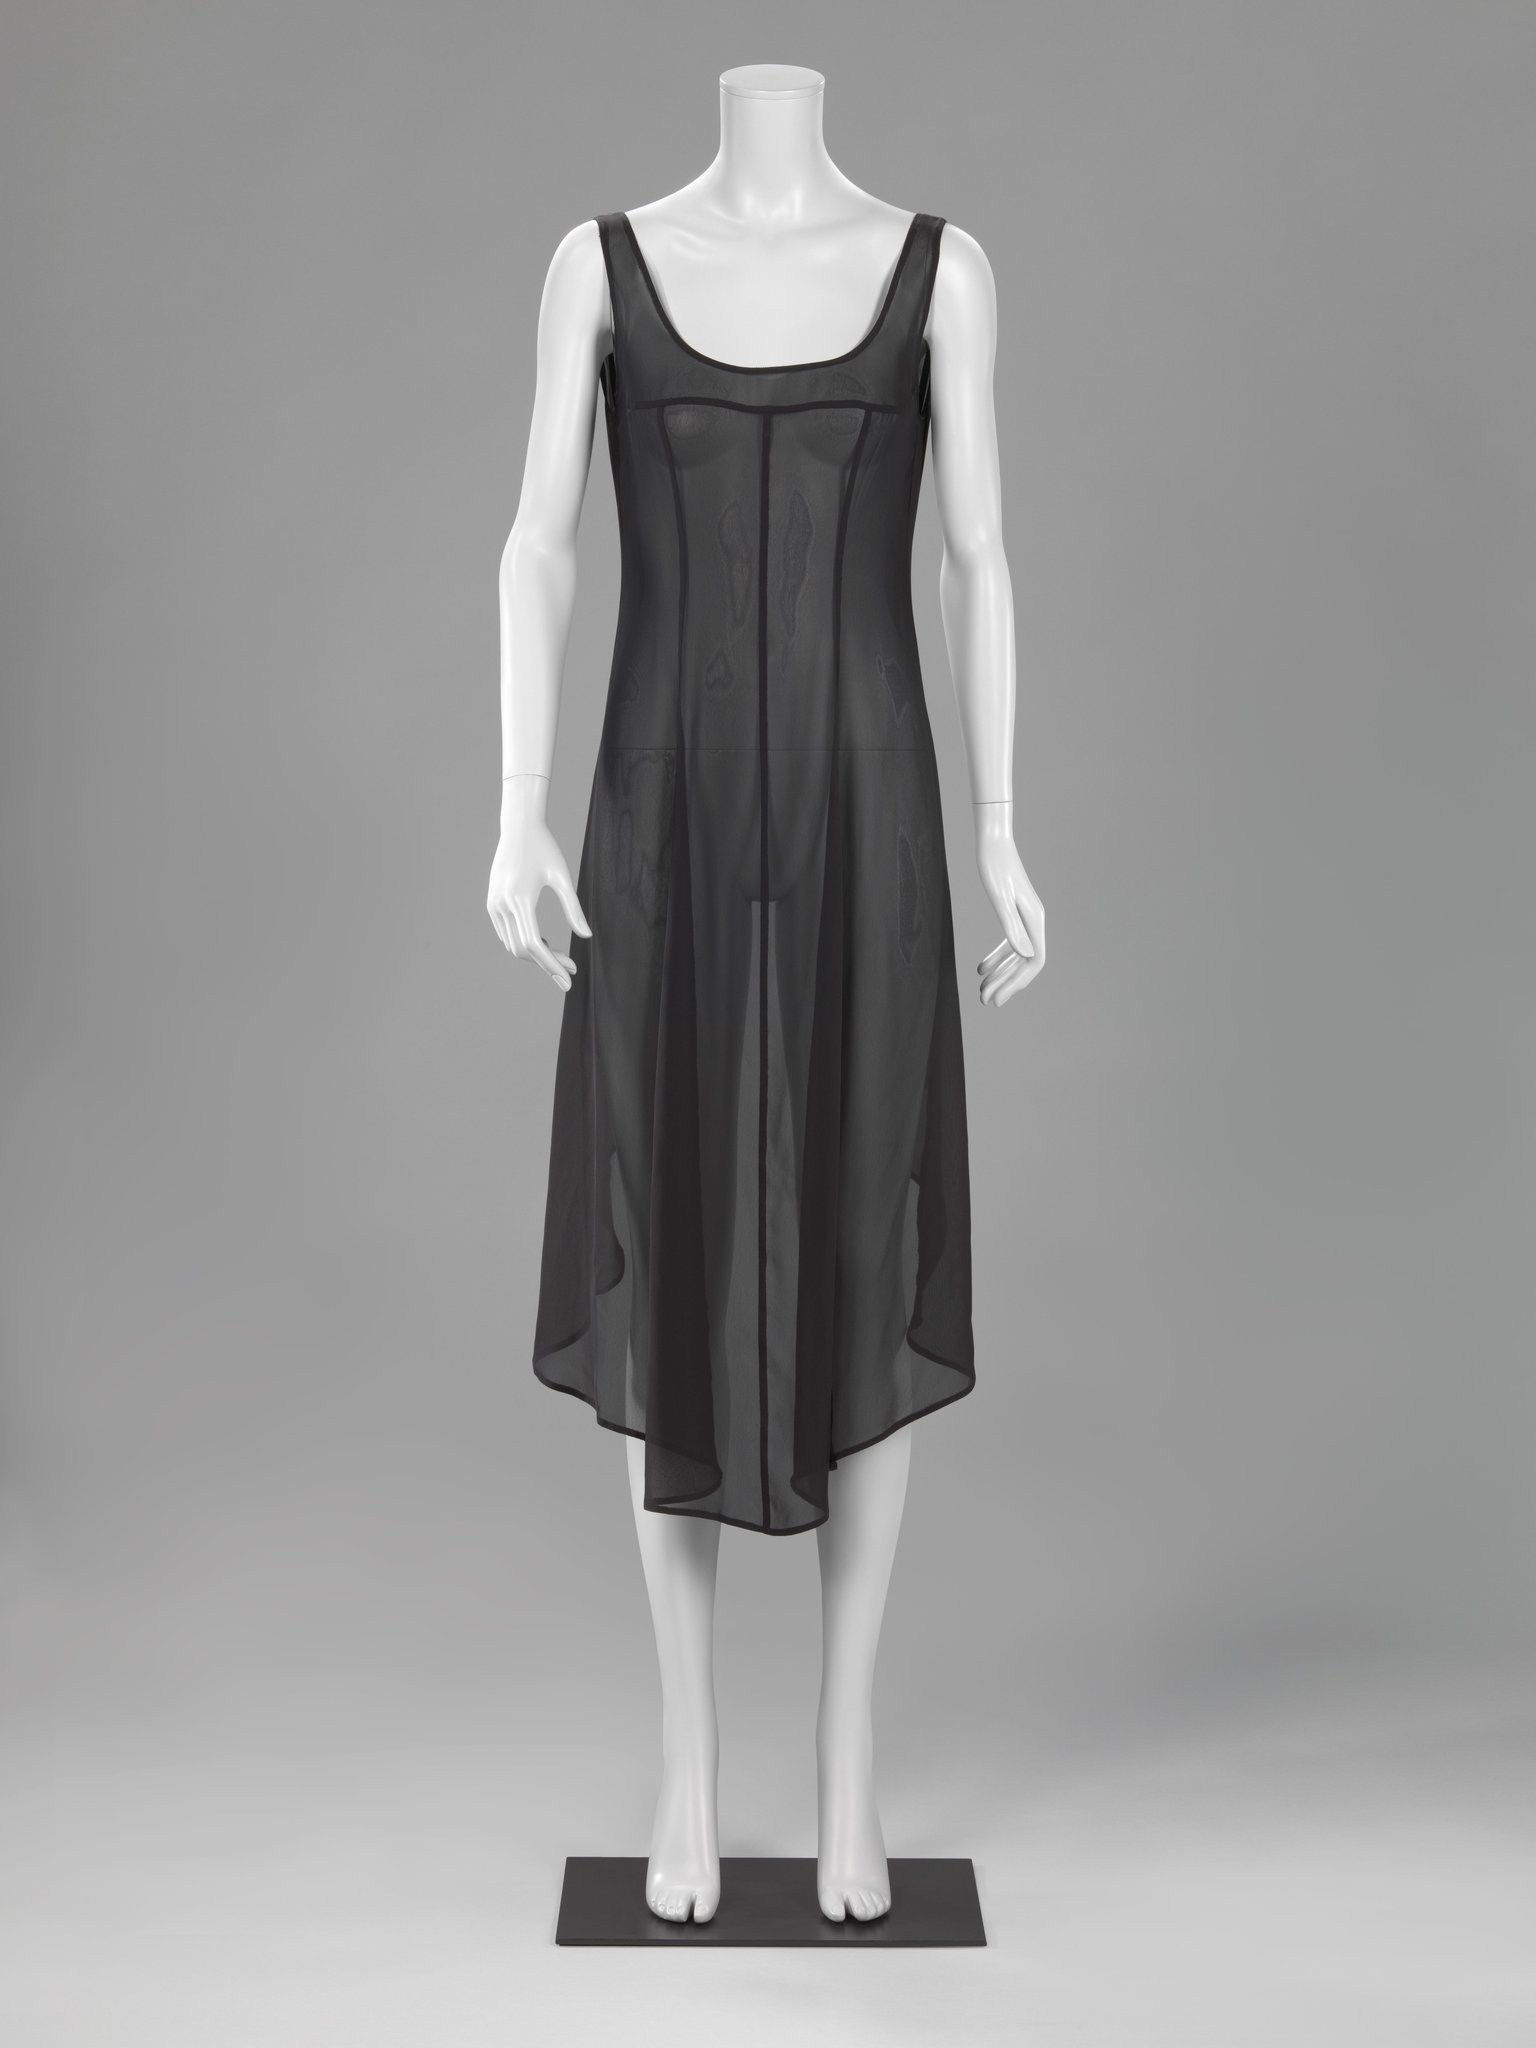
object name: lingerie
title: Bare Bottom Dress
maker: marlies dekkers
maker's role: modeontwerper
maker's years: 1965-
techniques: weave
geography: rotterdam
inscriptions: label: ‘Undressed/ by Marlies Dekkers/ classics 53953. Aan achterkant: wasvoorschriften.’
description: Jurk van zwarte, synthetische crepe de chine, met lage ruguitsnijding en extreem kort achterpand waardoor de billen van de draagster zichtbaar worden, zgn. blotebillenjurk.